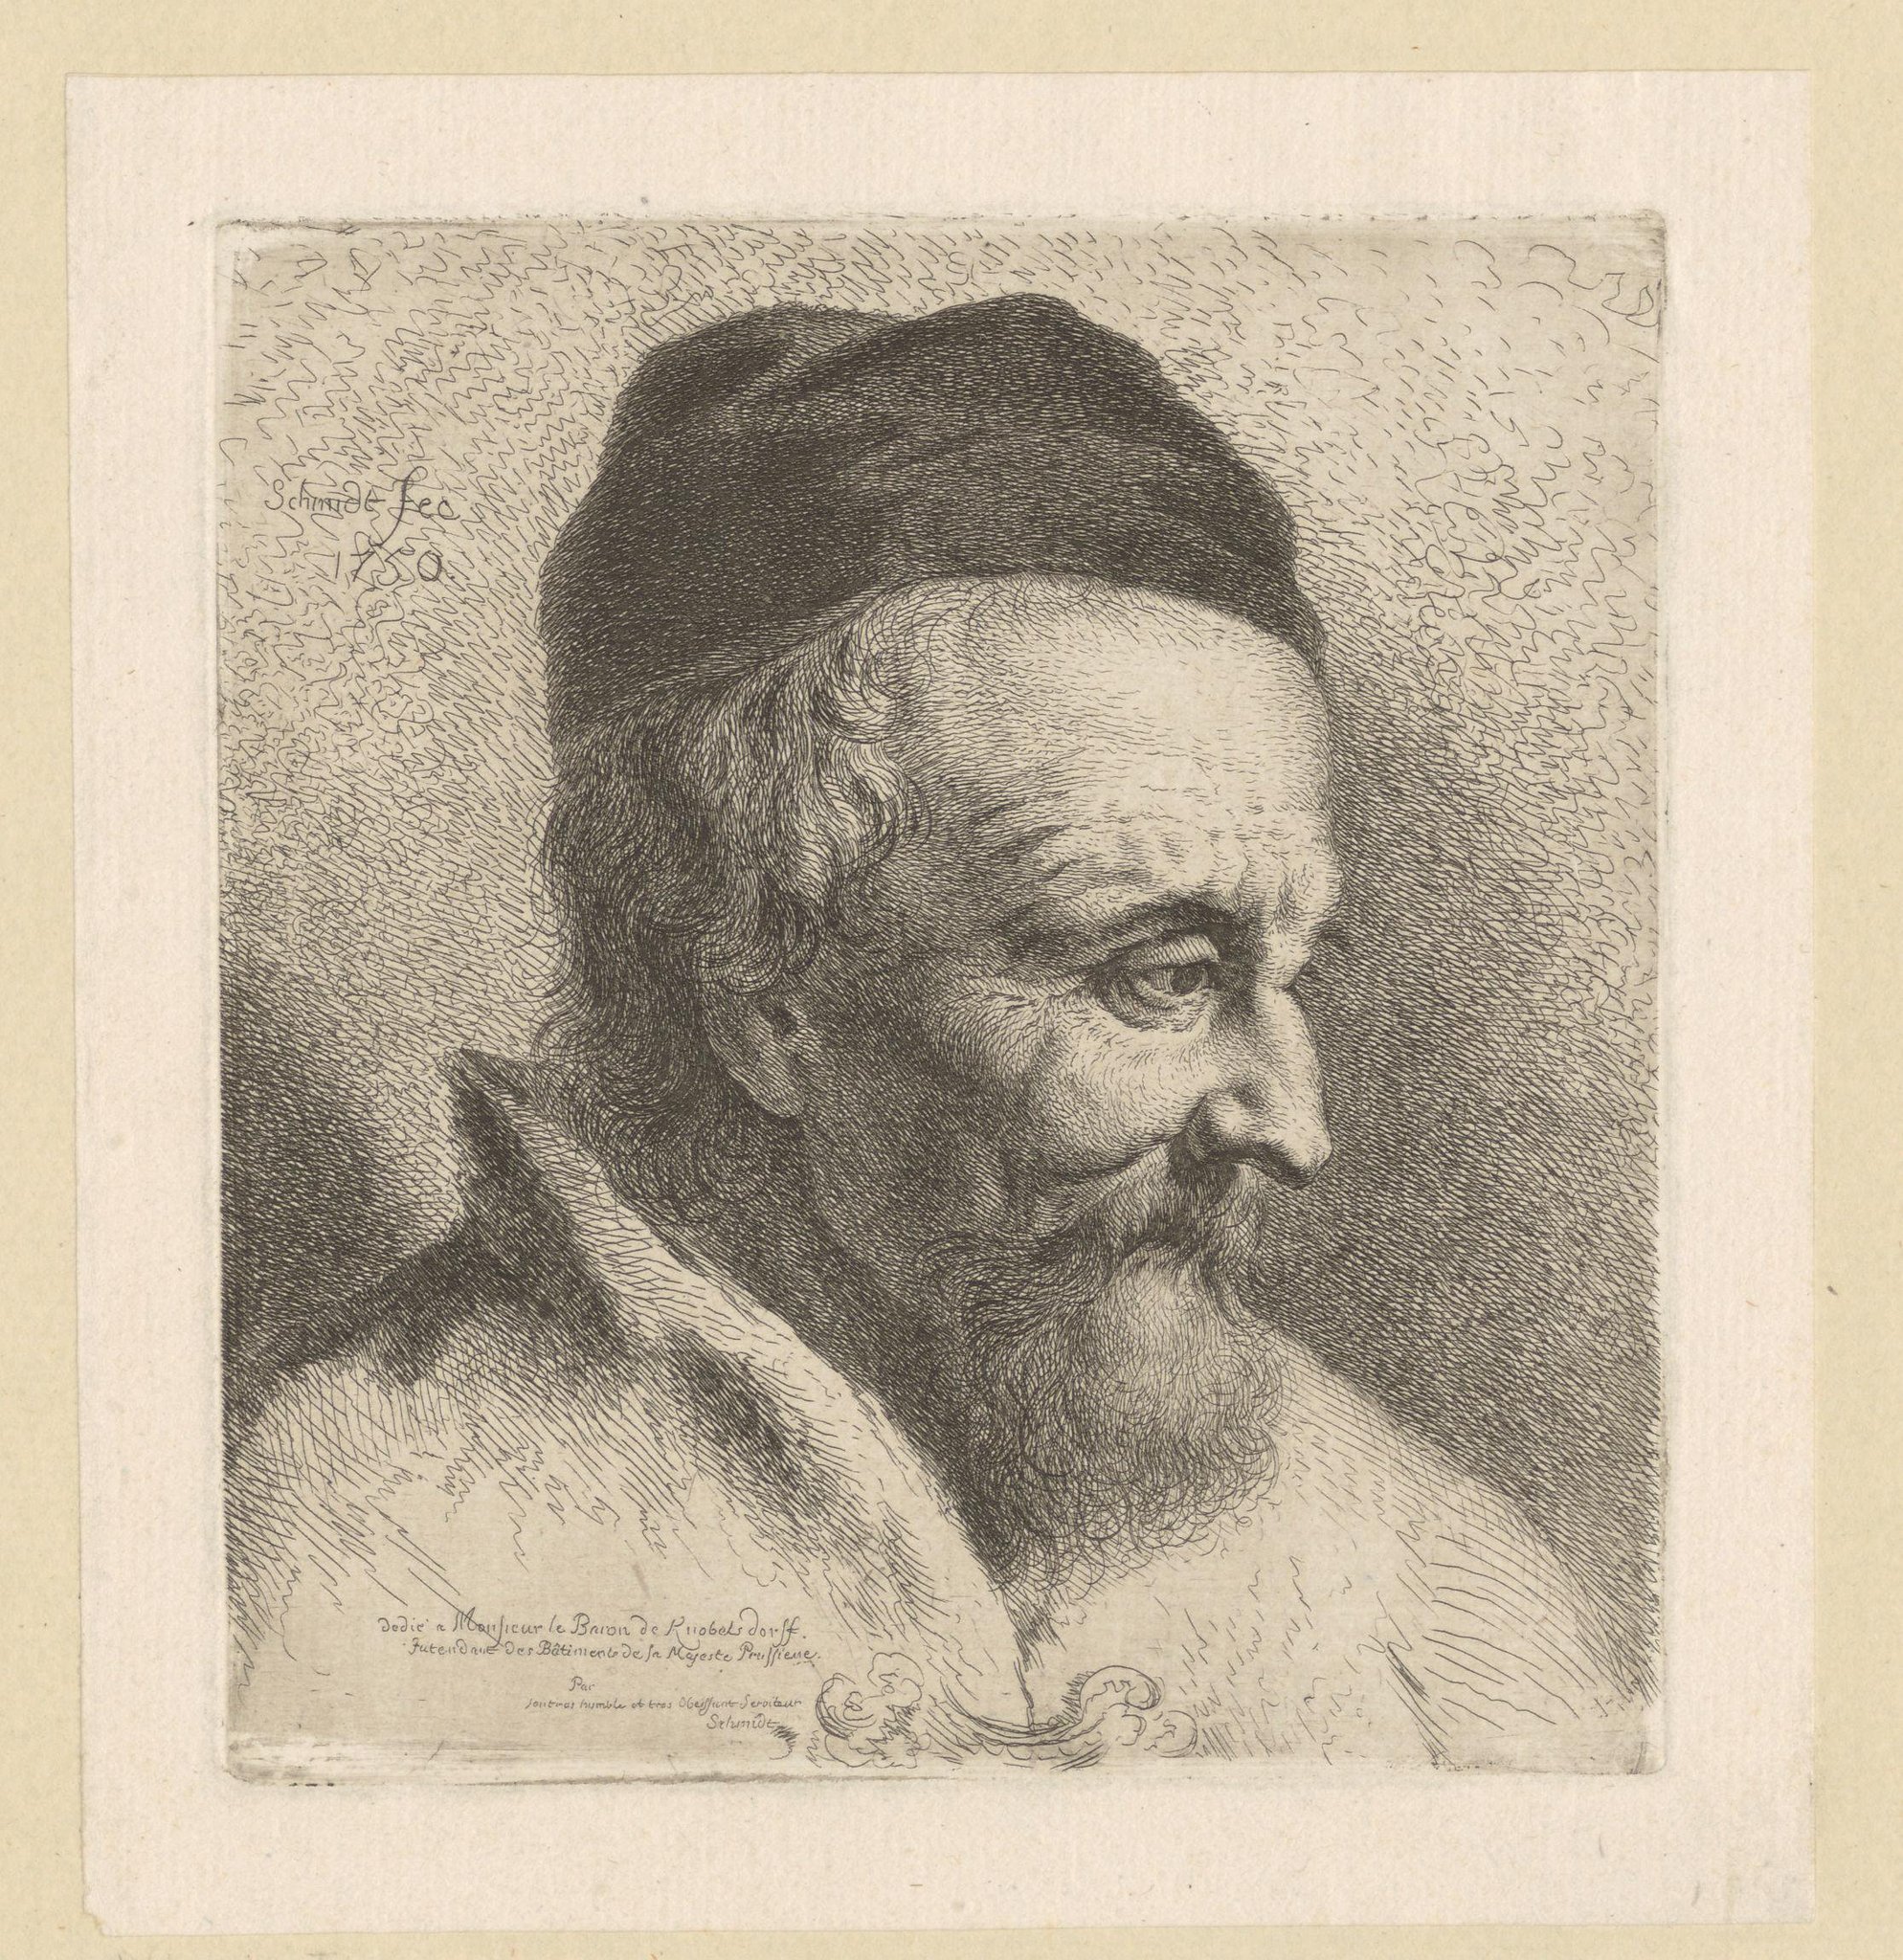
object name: print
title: Kop van een oude man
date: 1750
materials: paper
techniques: etching, intaglio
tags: old man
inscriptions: collector's mark: Lugt 240